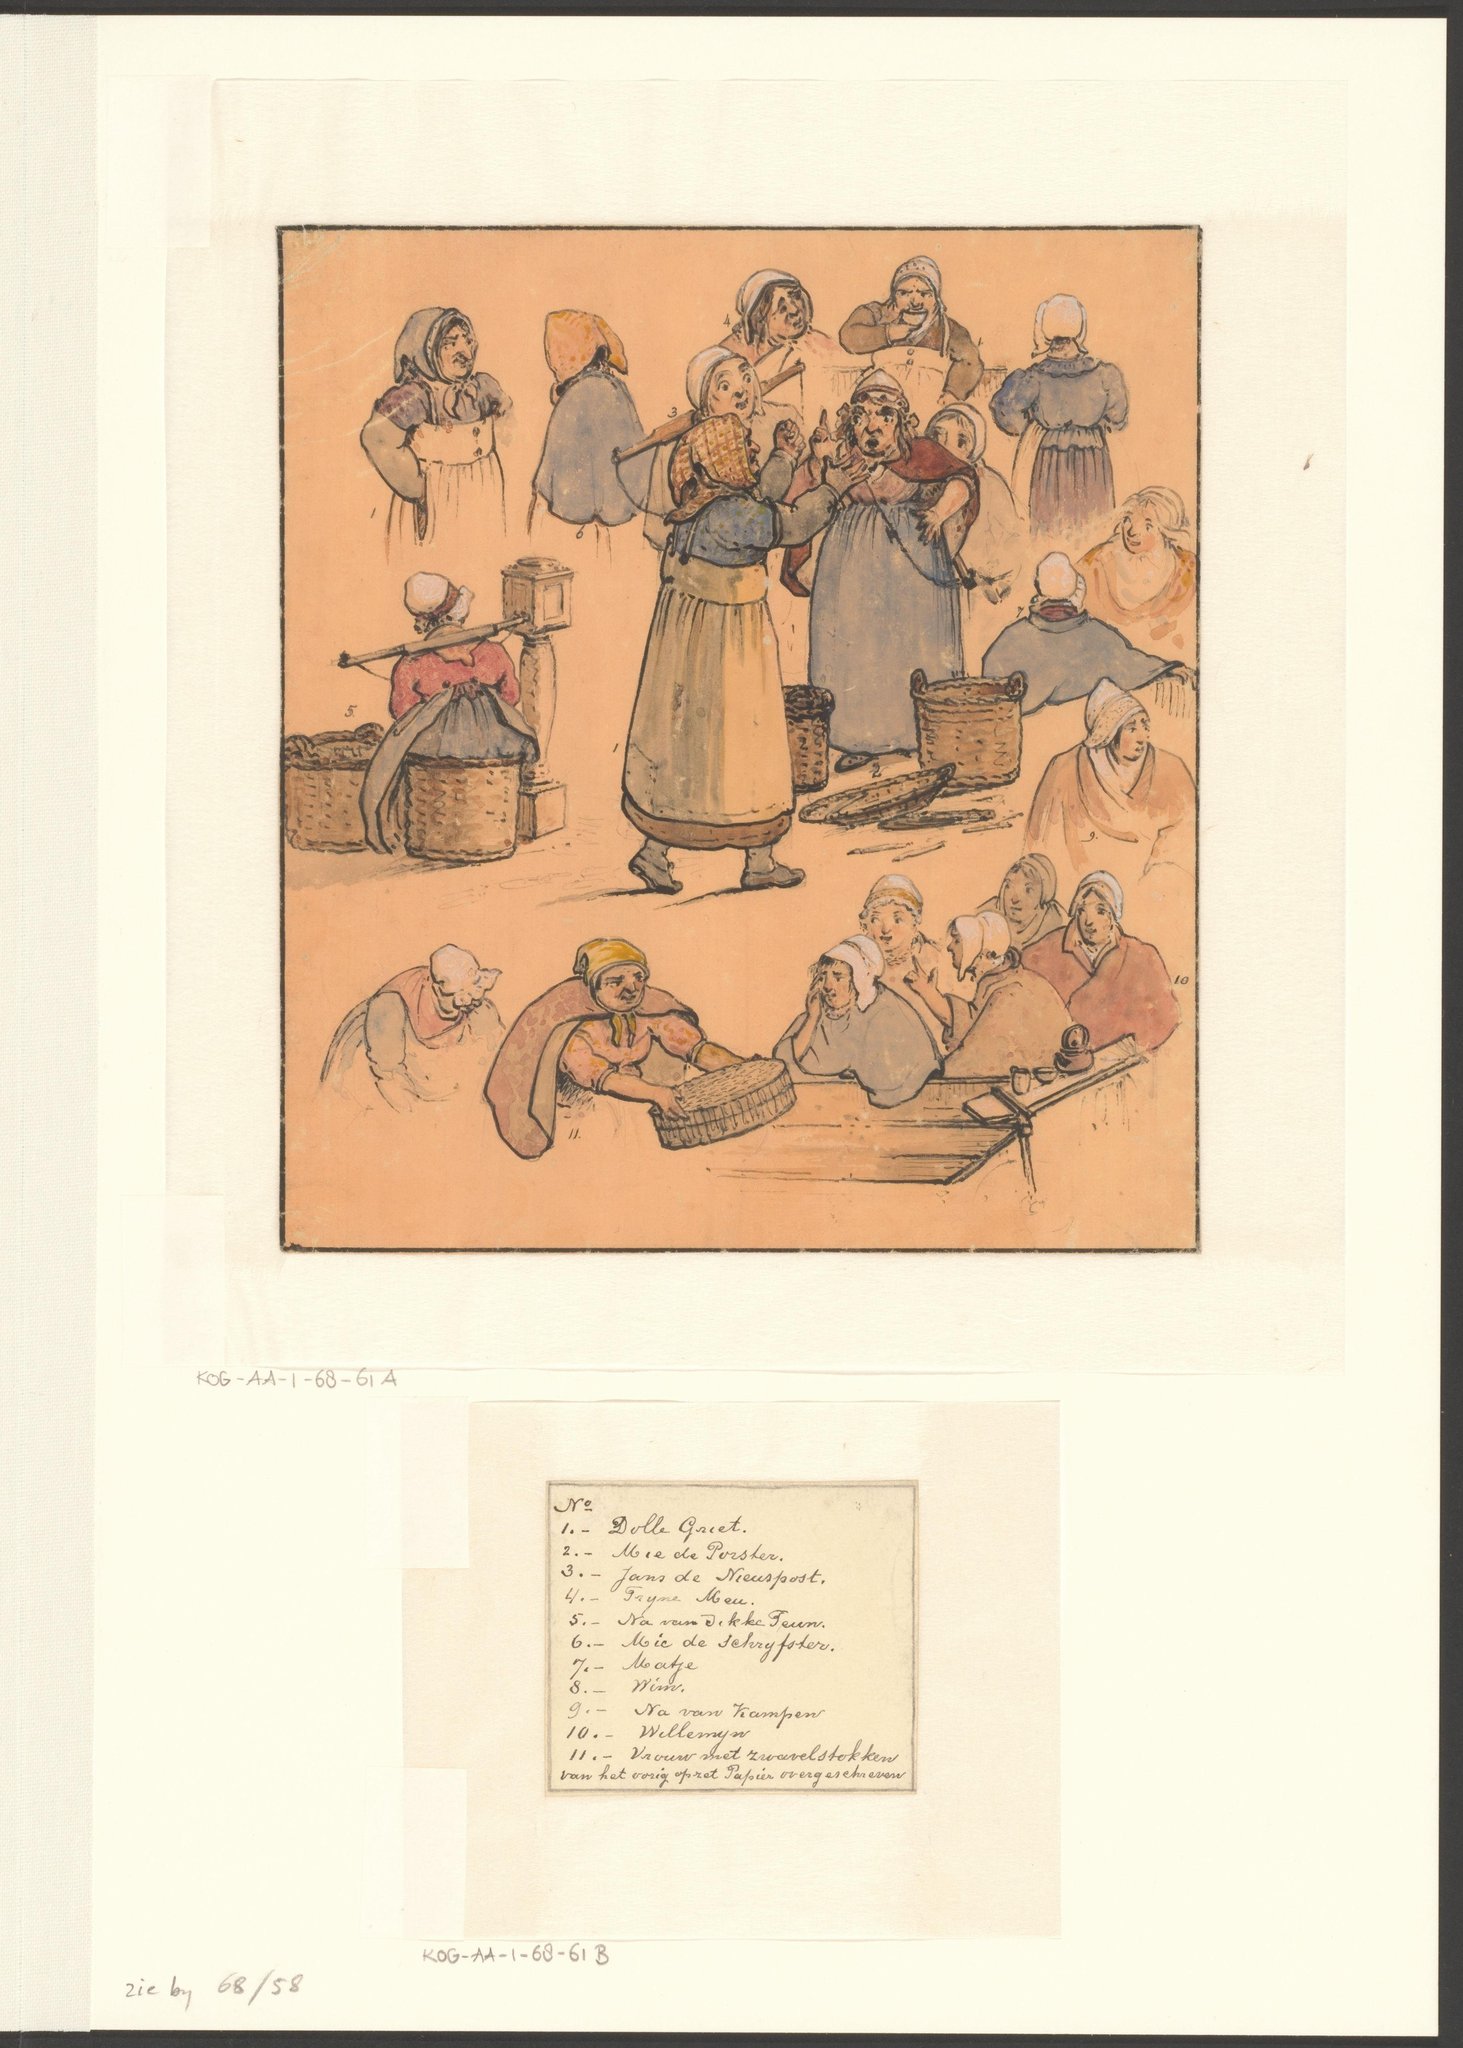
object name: drawing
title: Compositie met Amsterdamse volksvrouwen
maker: christiaan andriessen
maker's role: draughtsman, print maker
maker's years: 1775-1846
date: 1785-1846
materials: paint, gouache, ink, paper, pencil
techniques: brush, pen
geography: amsterdam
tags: folk costume, regional costume, amsterdam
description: Onderwerpsrubriek binnen de Atlas Amsterdam: Amsterdamsche Typen AB - A.